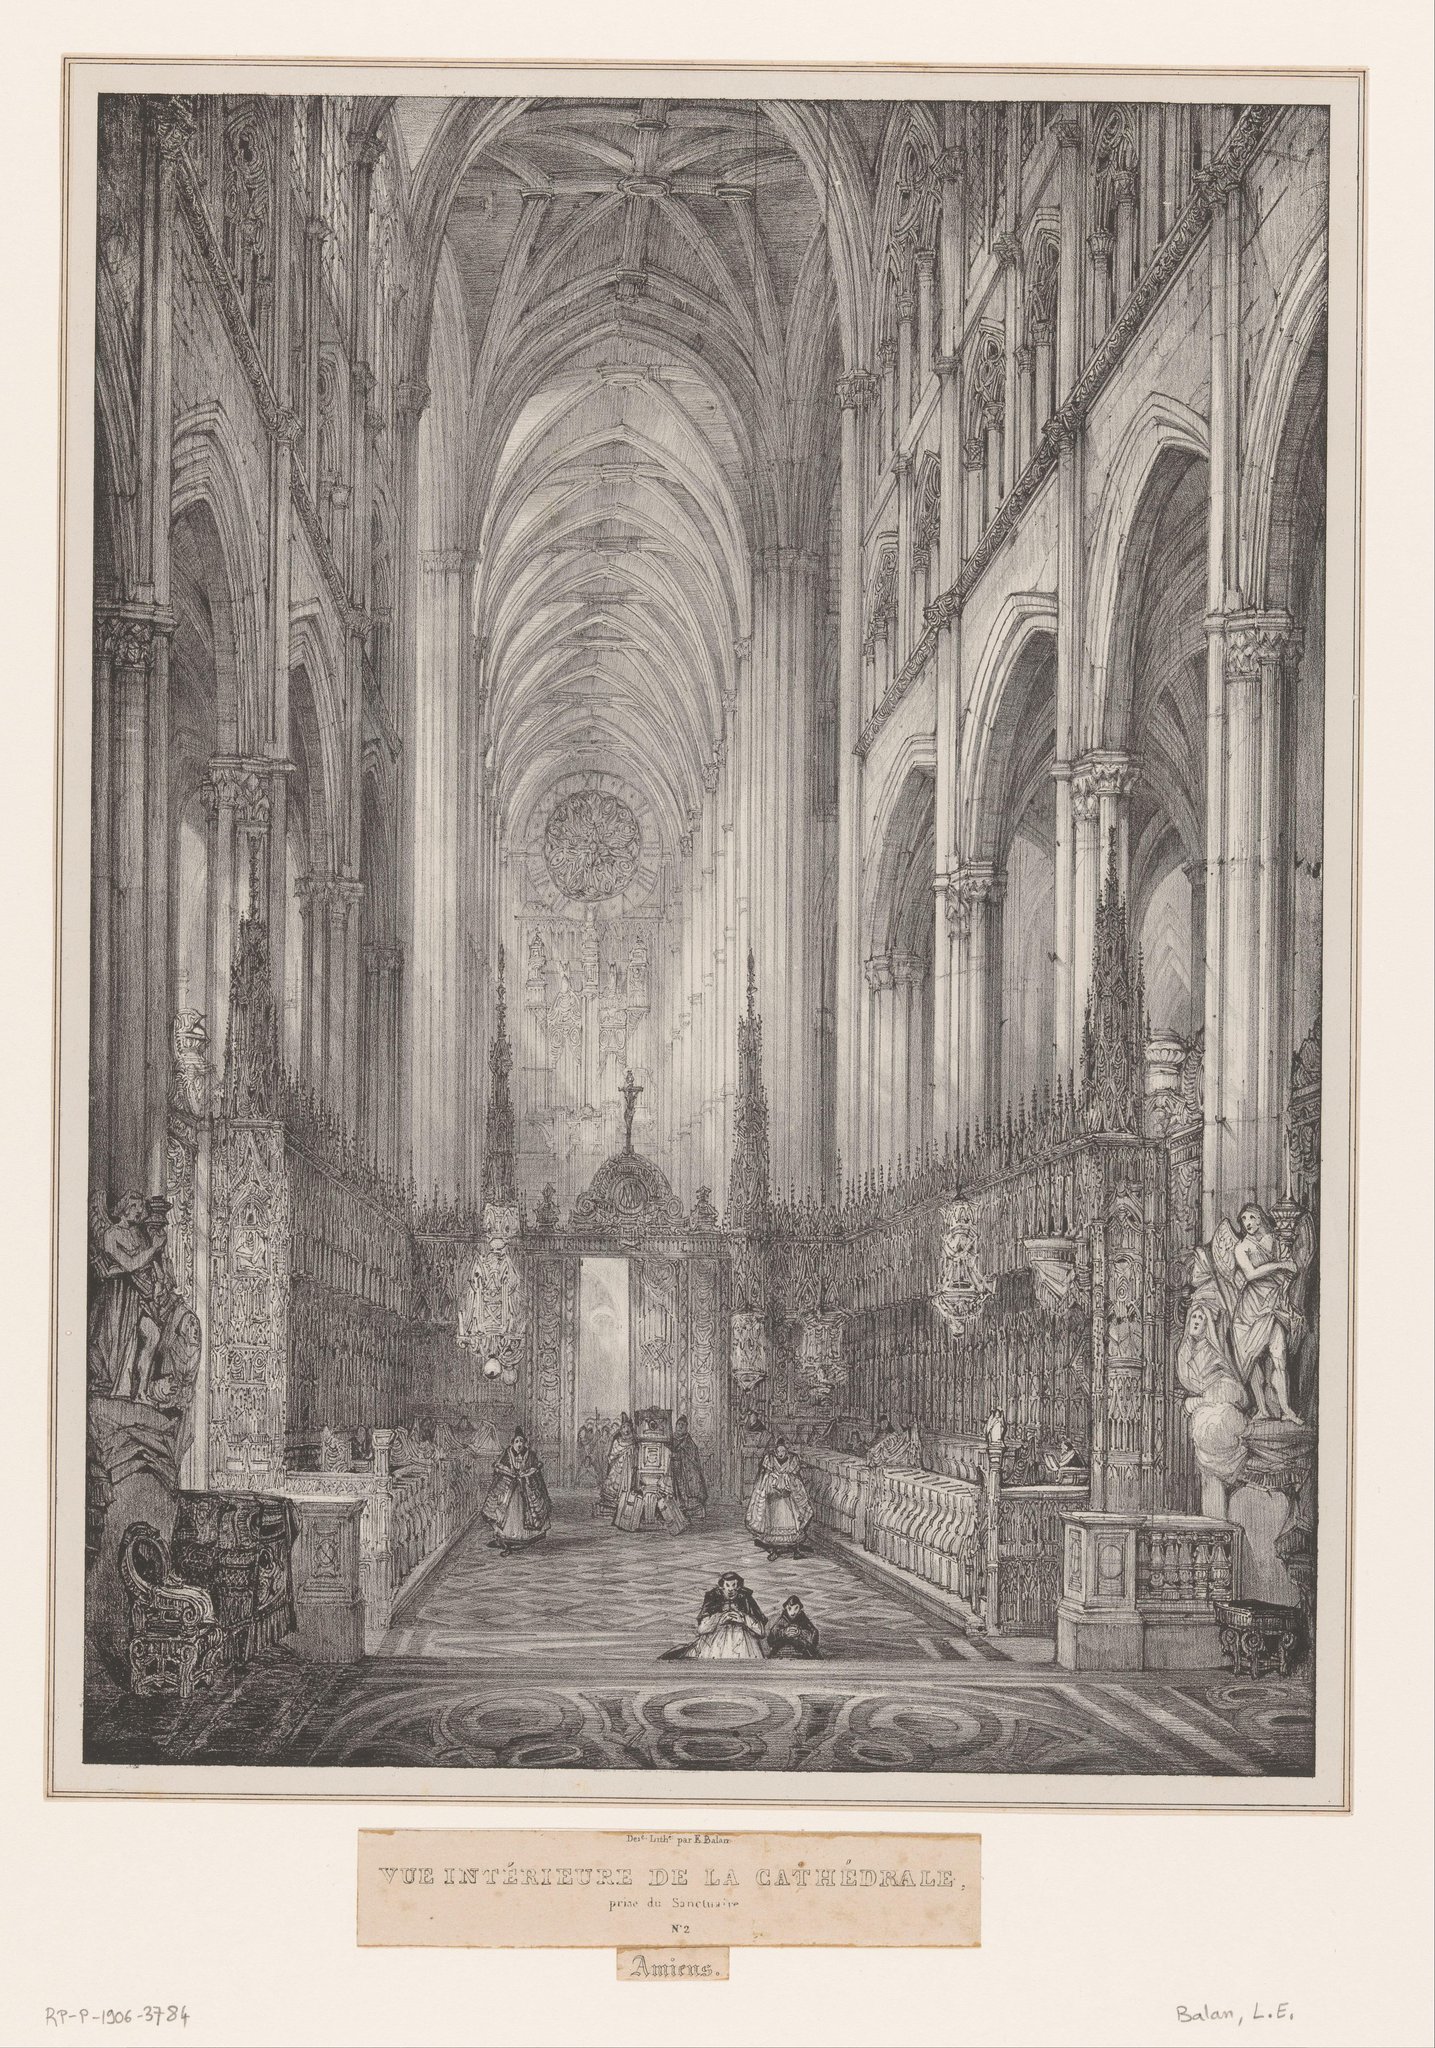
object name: print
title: Stadsgezichten van Amiens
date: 1837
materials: paper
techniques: lithograph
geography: amiens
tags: interior of church, notre-dame d'amiens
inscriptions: collector's mark: Lugt 2228a